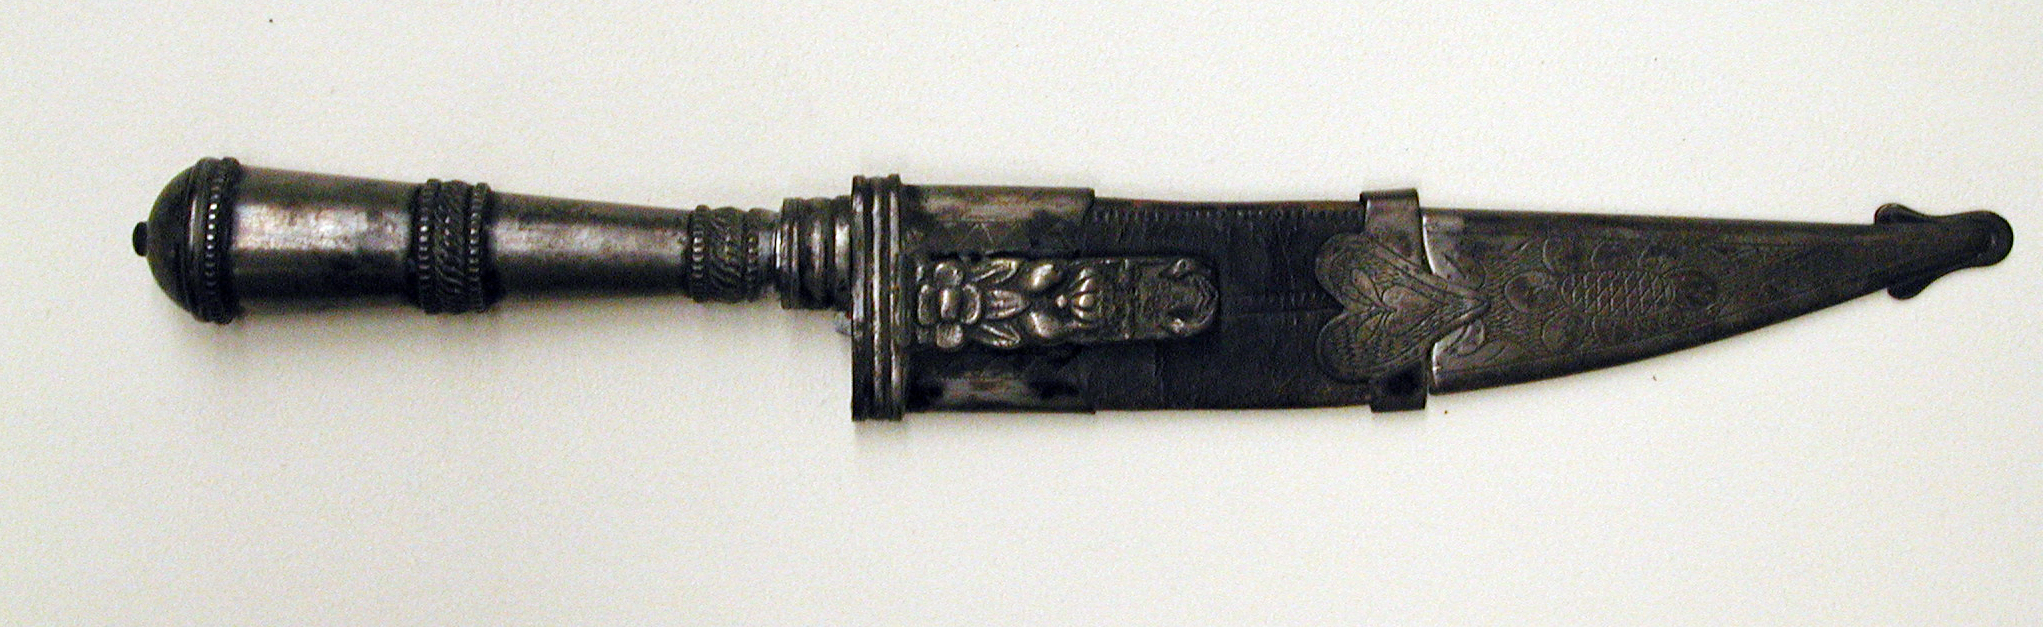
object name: hunting knife with sheath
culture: swiss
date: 1801-1900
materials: leather, silver, steel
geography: switzerland